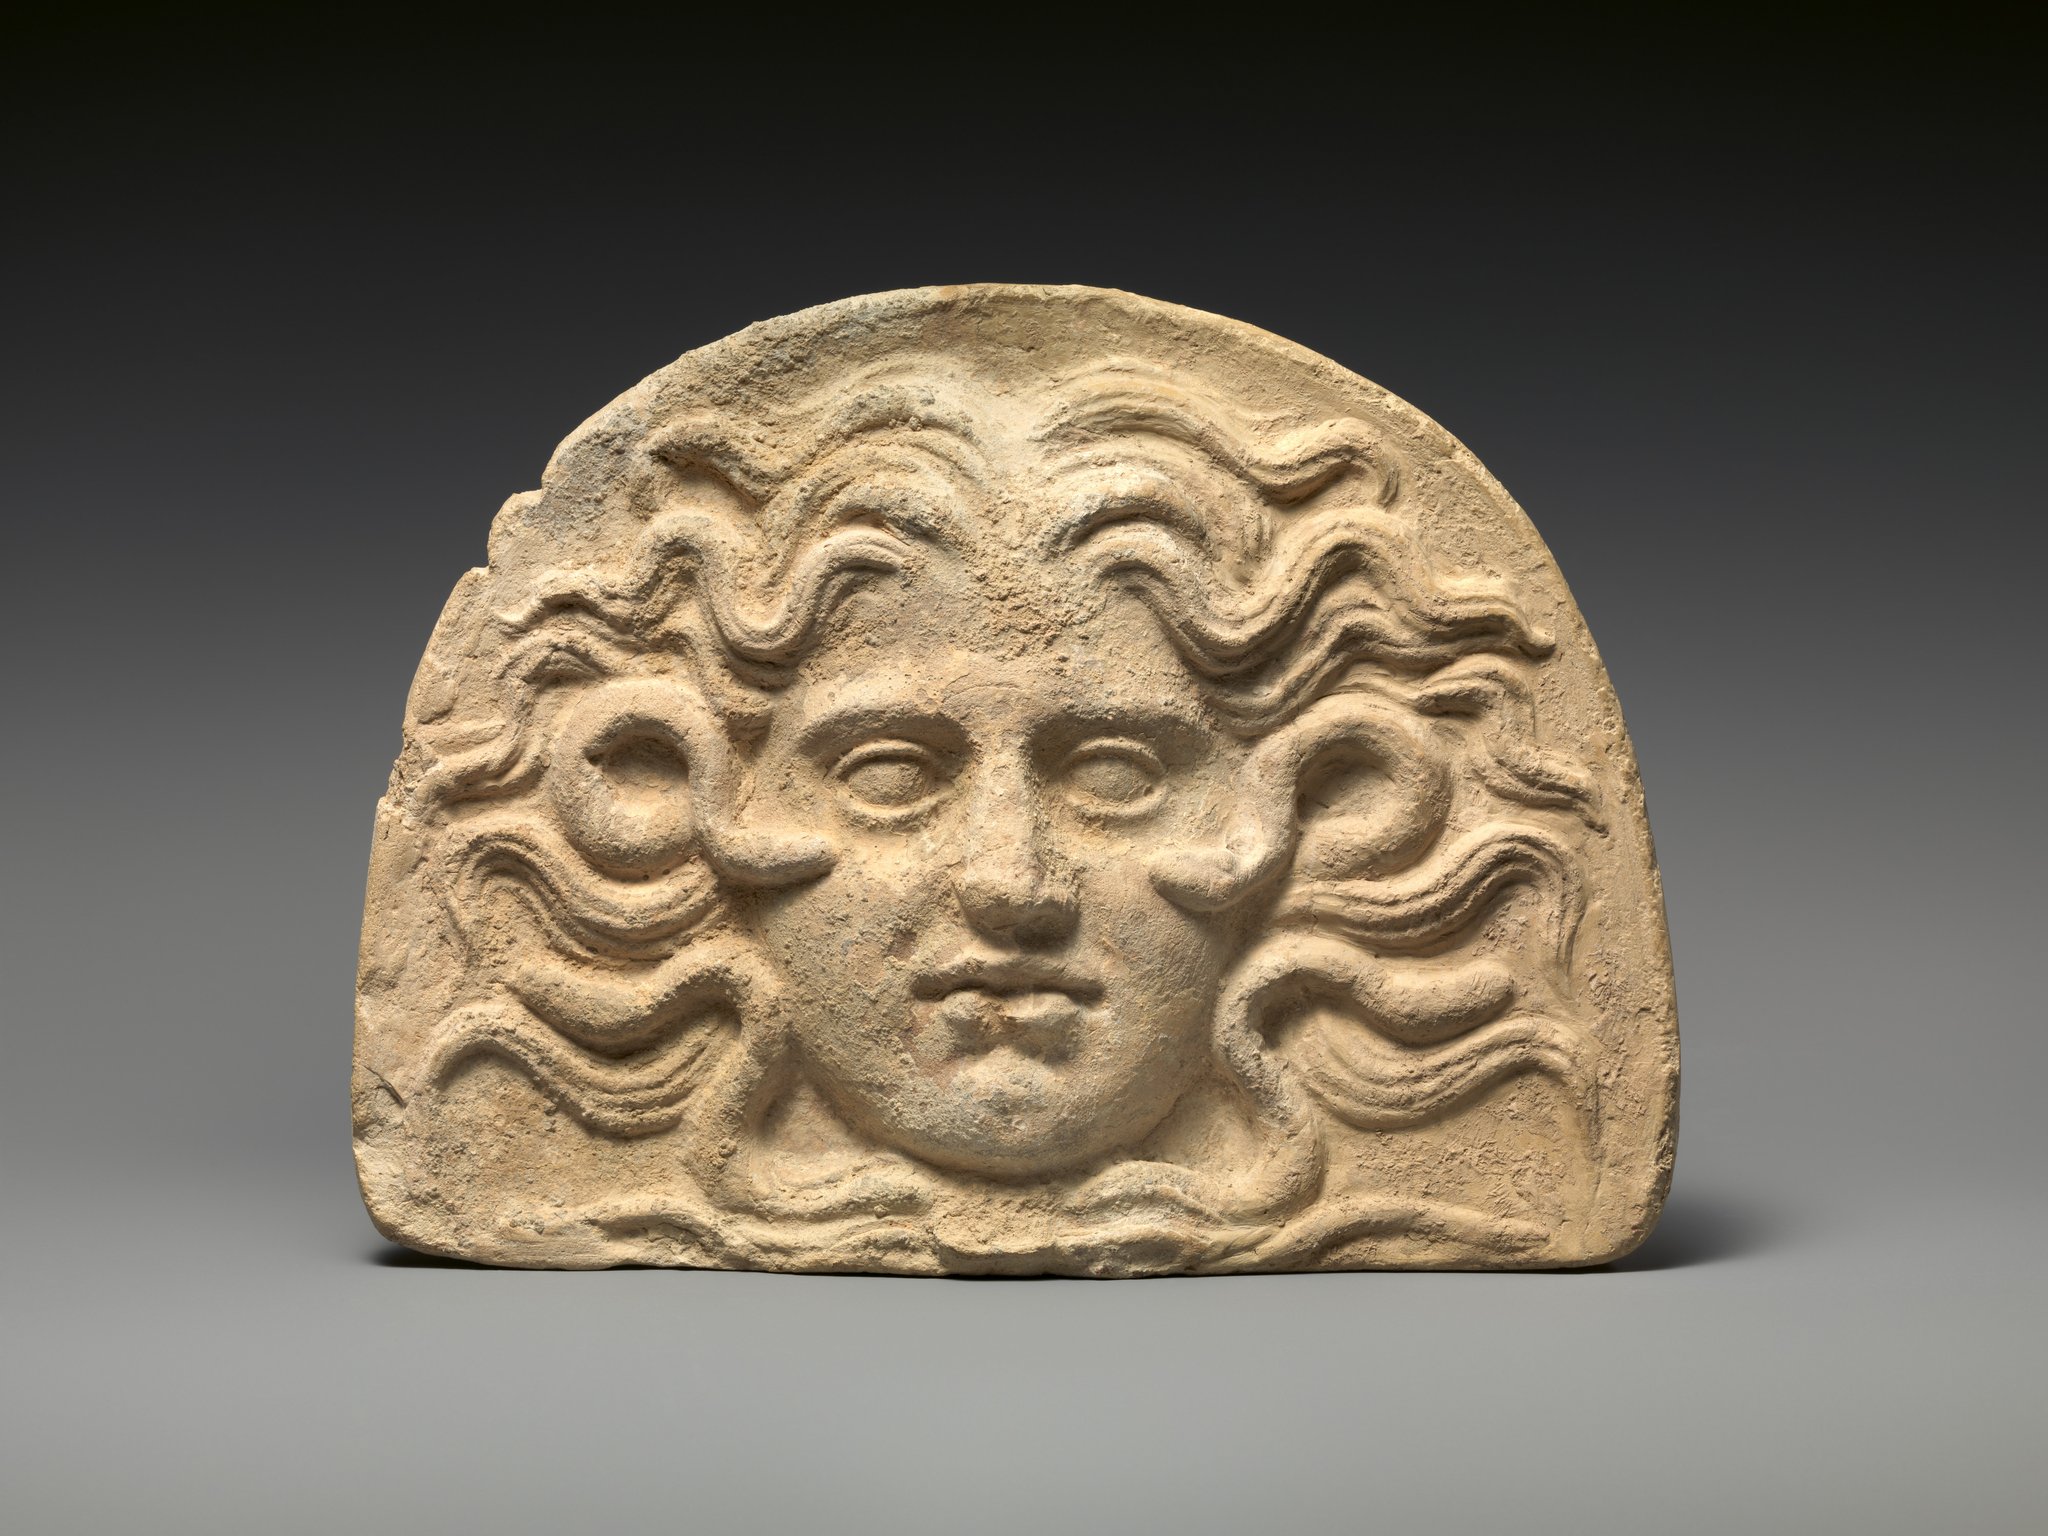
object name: antefix, head of medusa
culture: greek or south italian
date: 400-301 BCE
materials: terracotta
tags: medusa